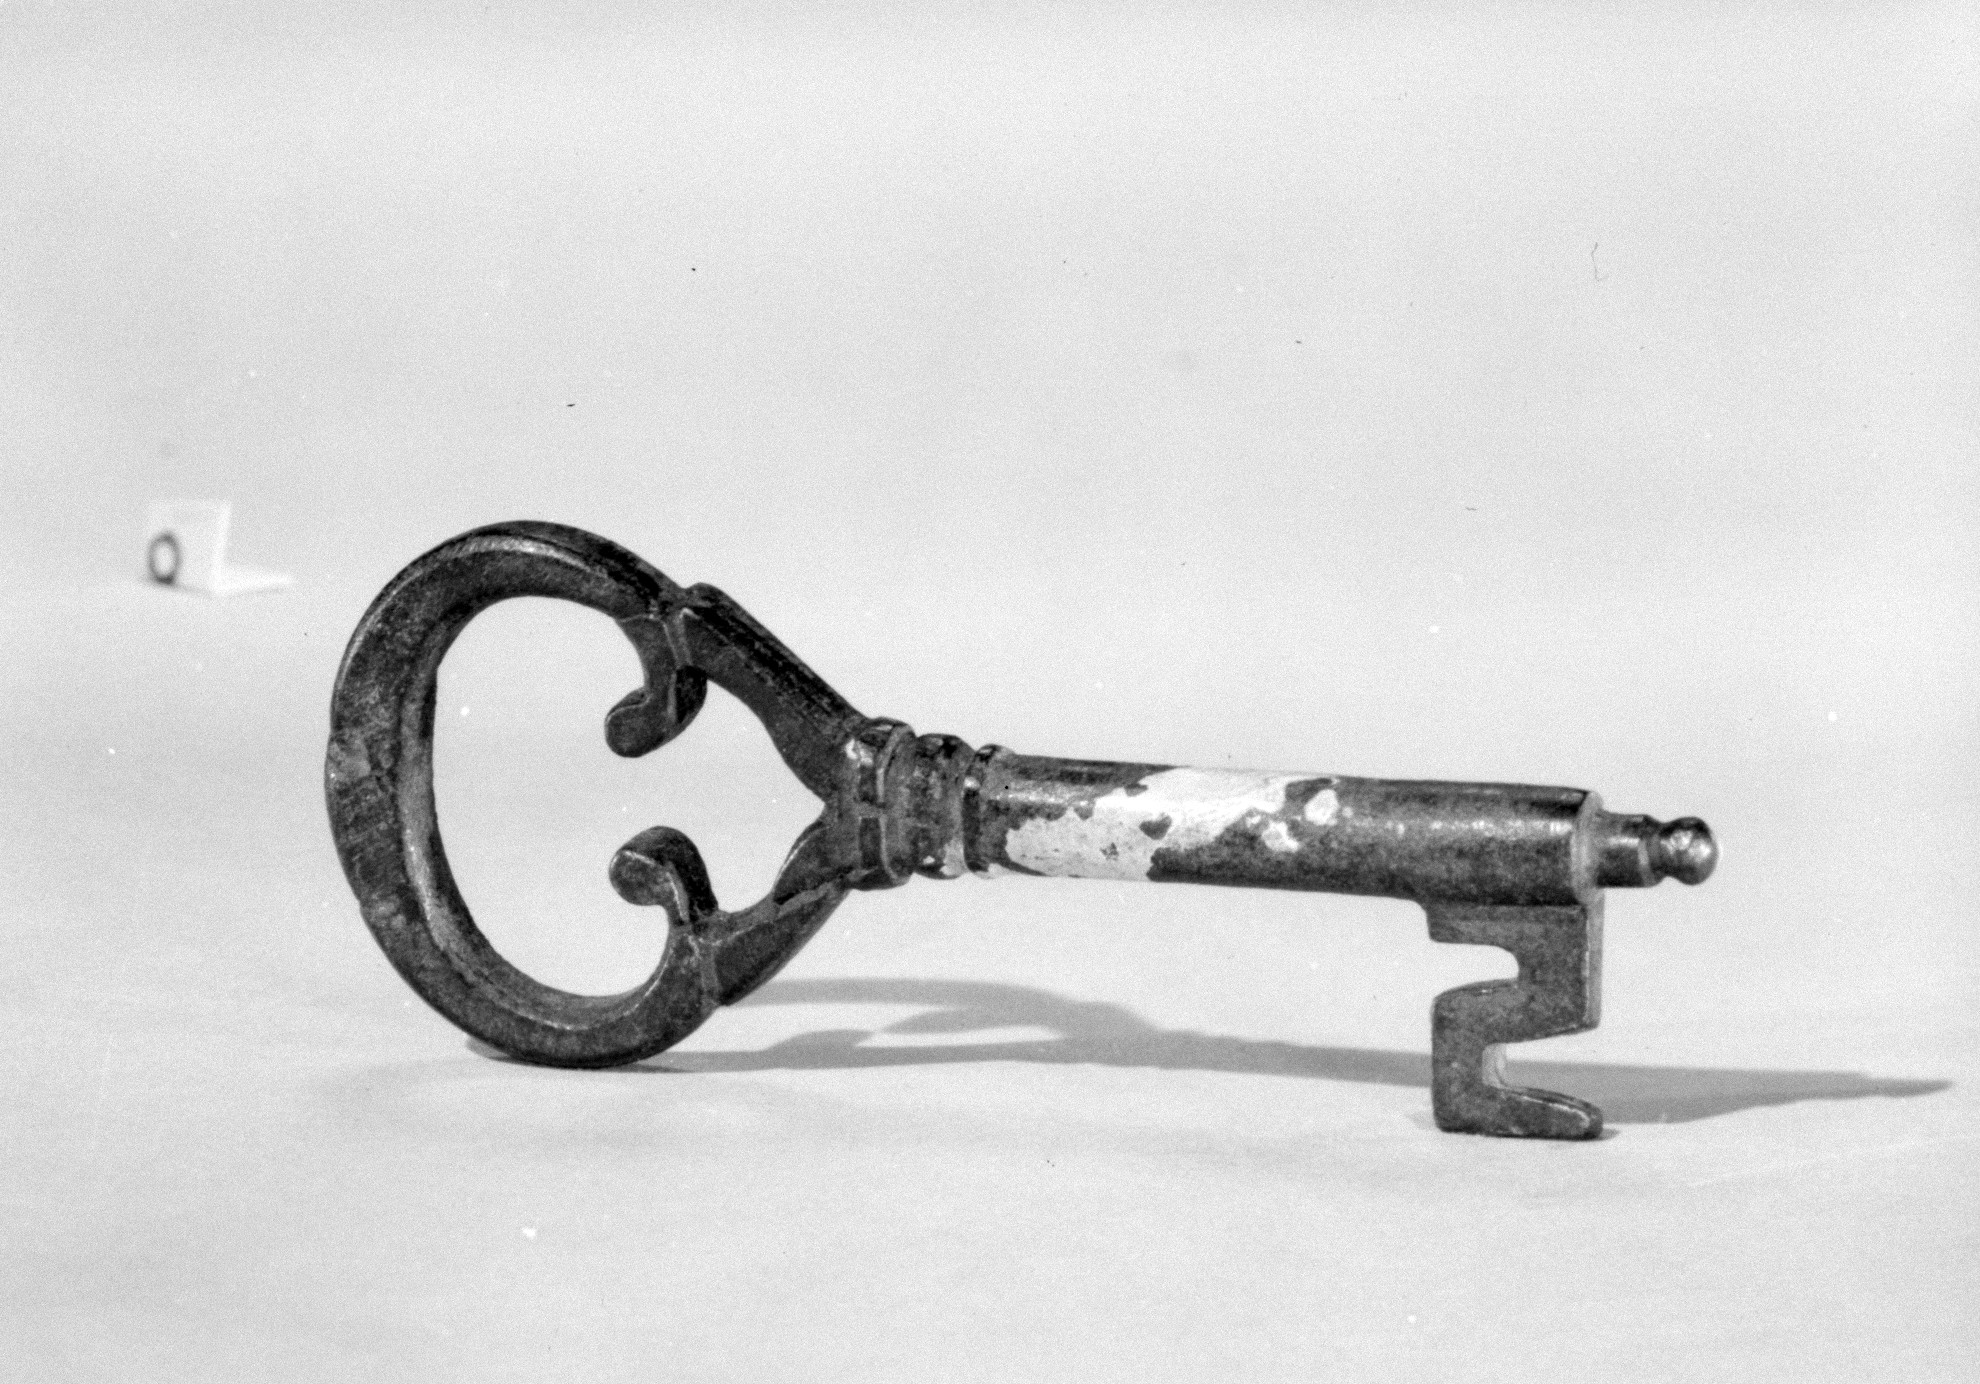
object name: key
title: Pin key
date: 1601-1800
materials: iron